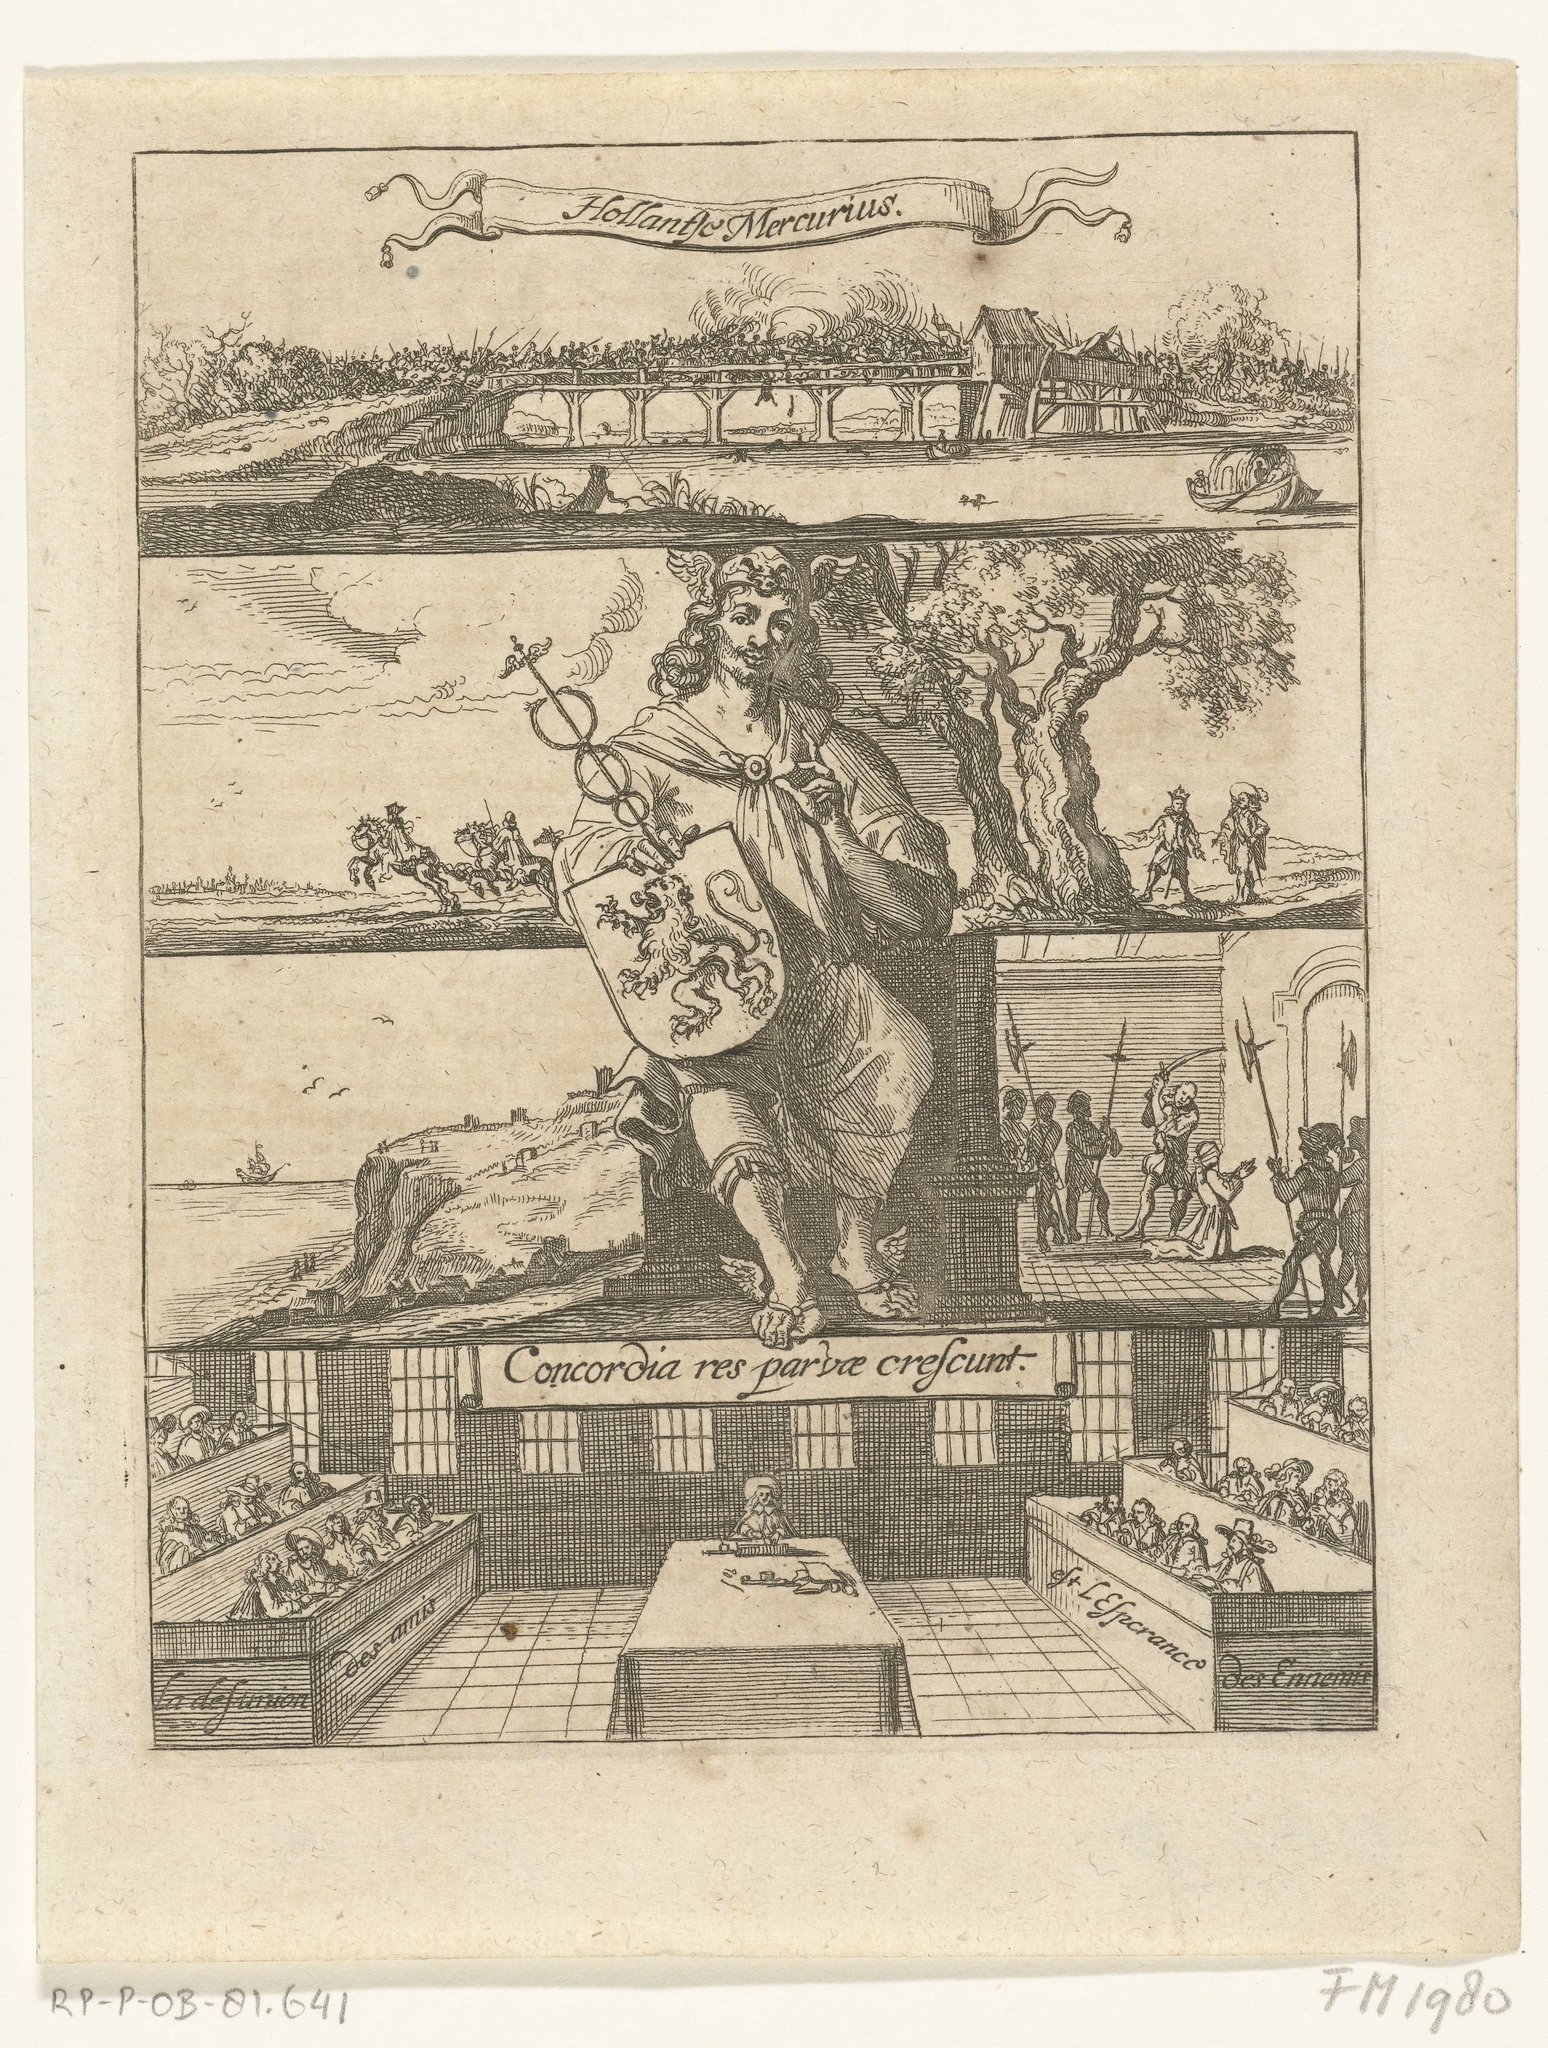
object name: print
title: Titelprent voor de Hollantsche Mercurius van 1651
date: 1652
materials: paper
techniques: etching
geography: haarlem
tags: warfare; military affairs, specific aspects, allegorical aspects of mercury; mercury as patron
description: Titelprent voor de Hollantsche Mercurius van 1651. Vier stroken met in het klein de belangrijkste gebeurtenissen uit het jaar. Centraal de zittende Mercurius met wapenschild van Holland.